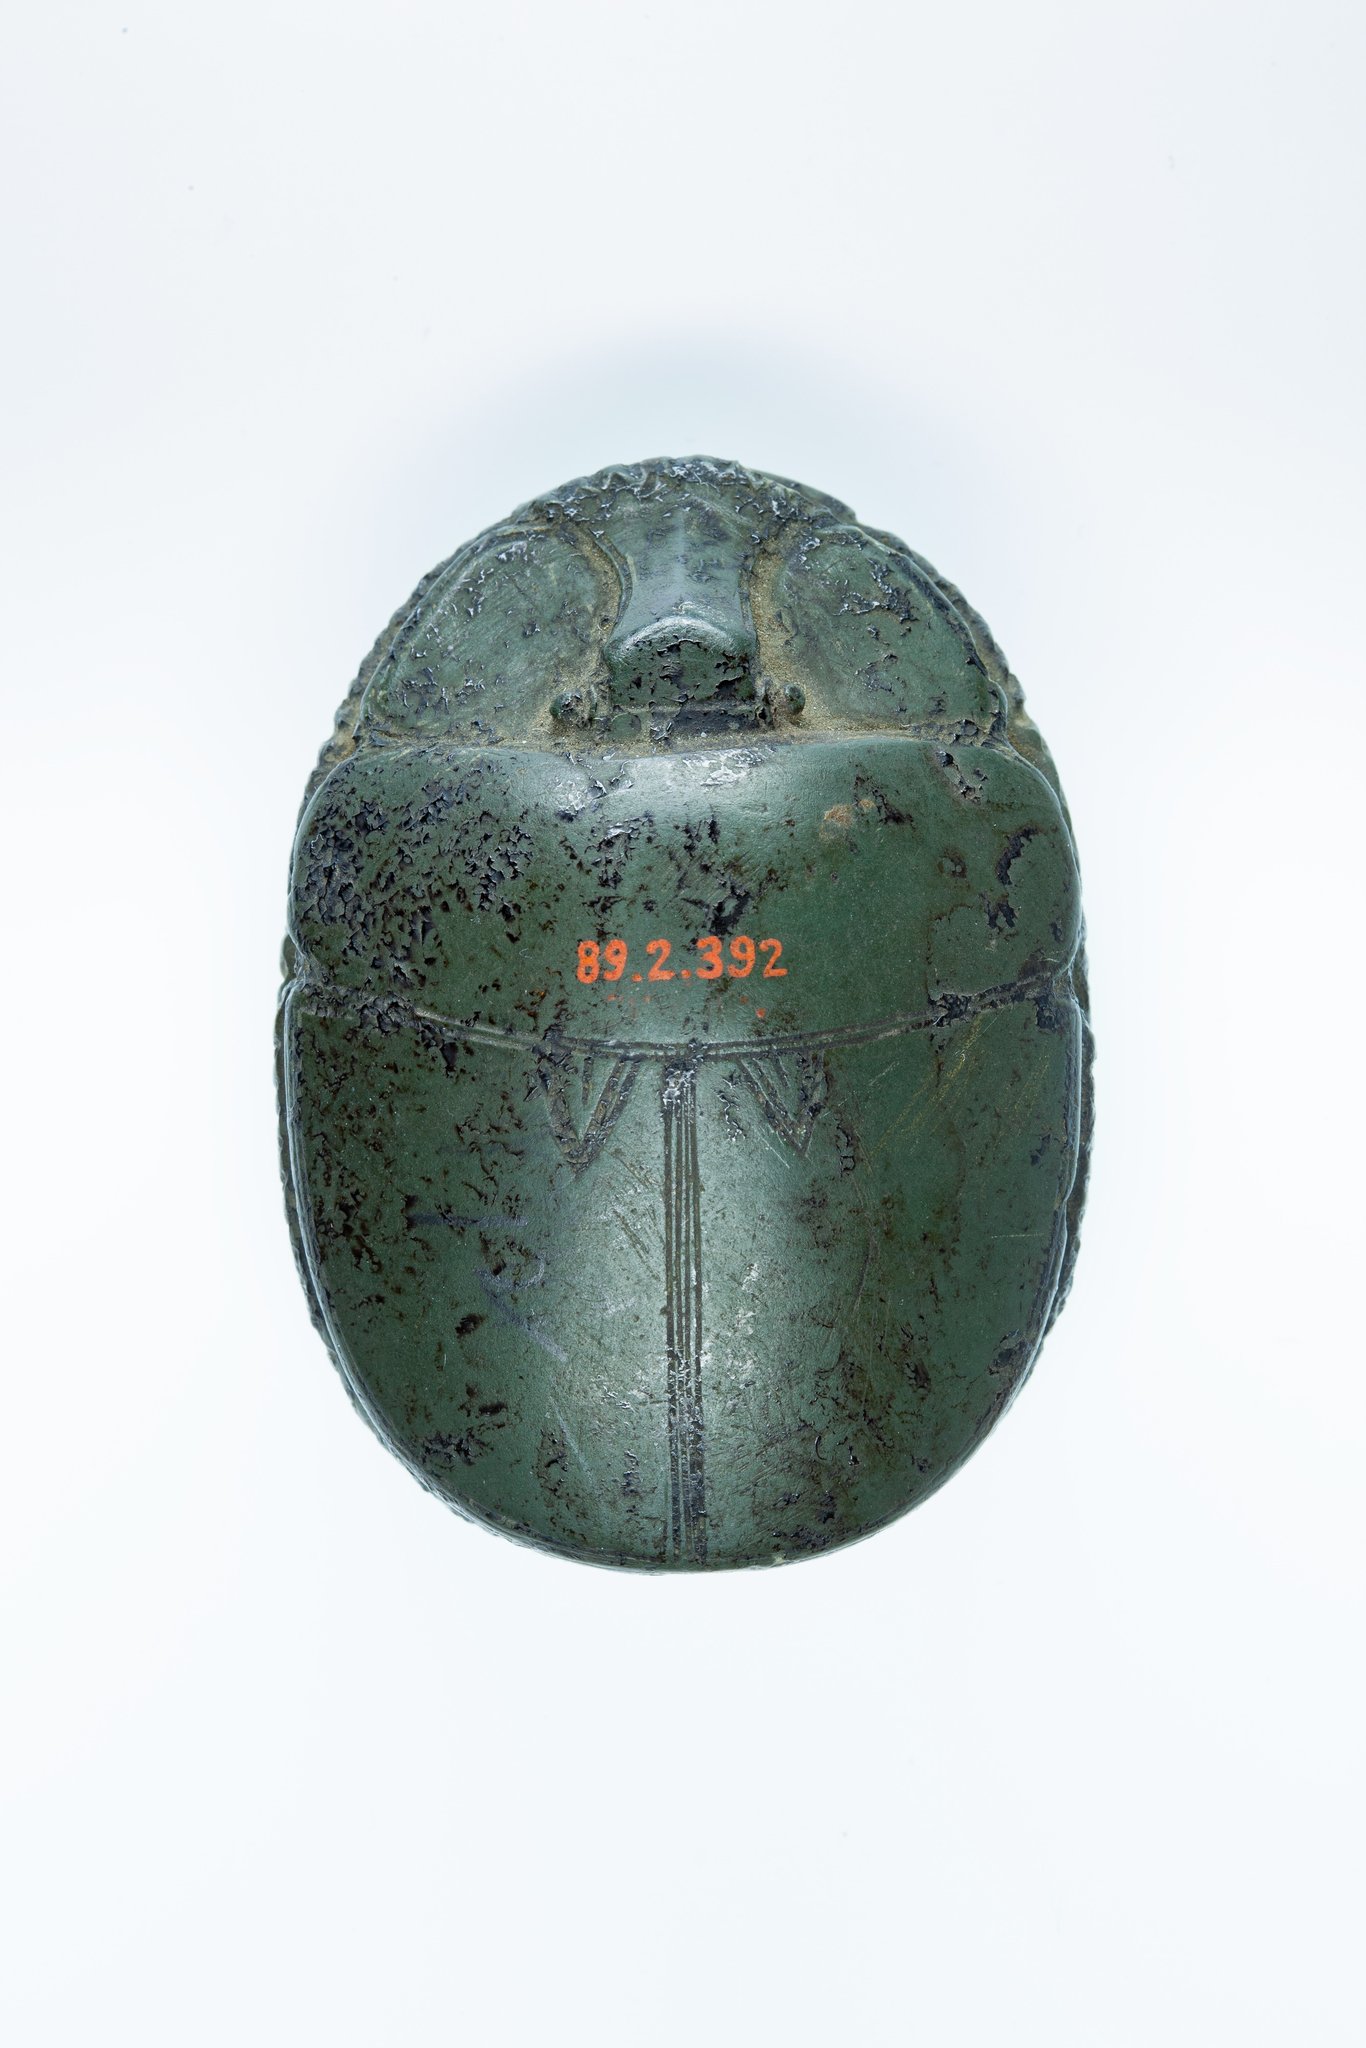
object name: heart scarab, amenemhat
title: Heart Scarab of Amenemhat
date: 1550-1295 BCE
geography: egypt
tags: scarabs